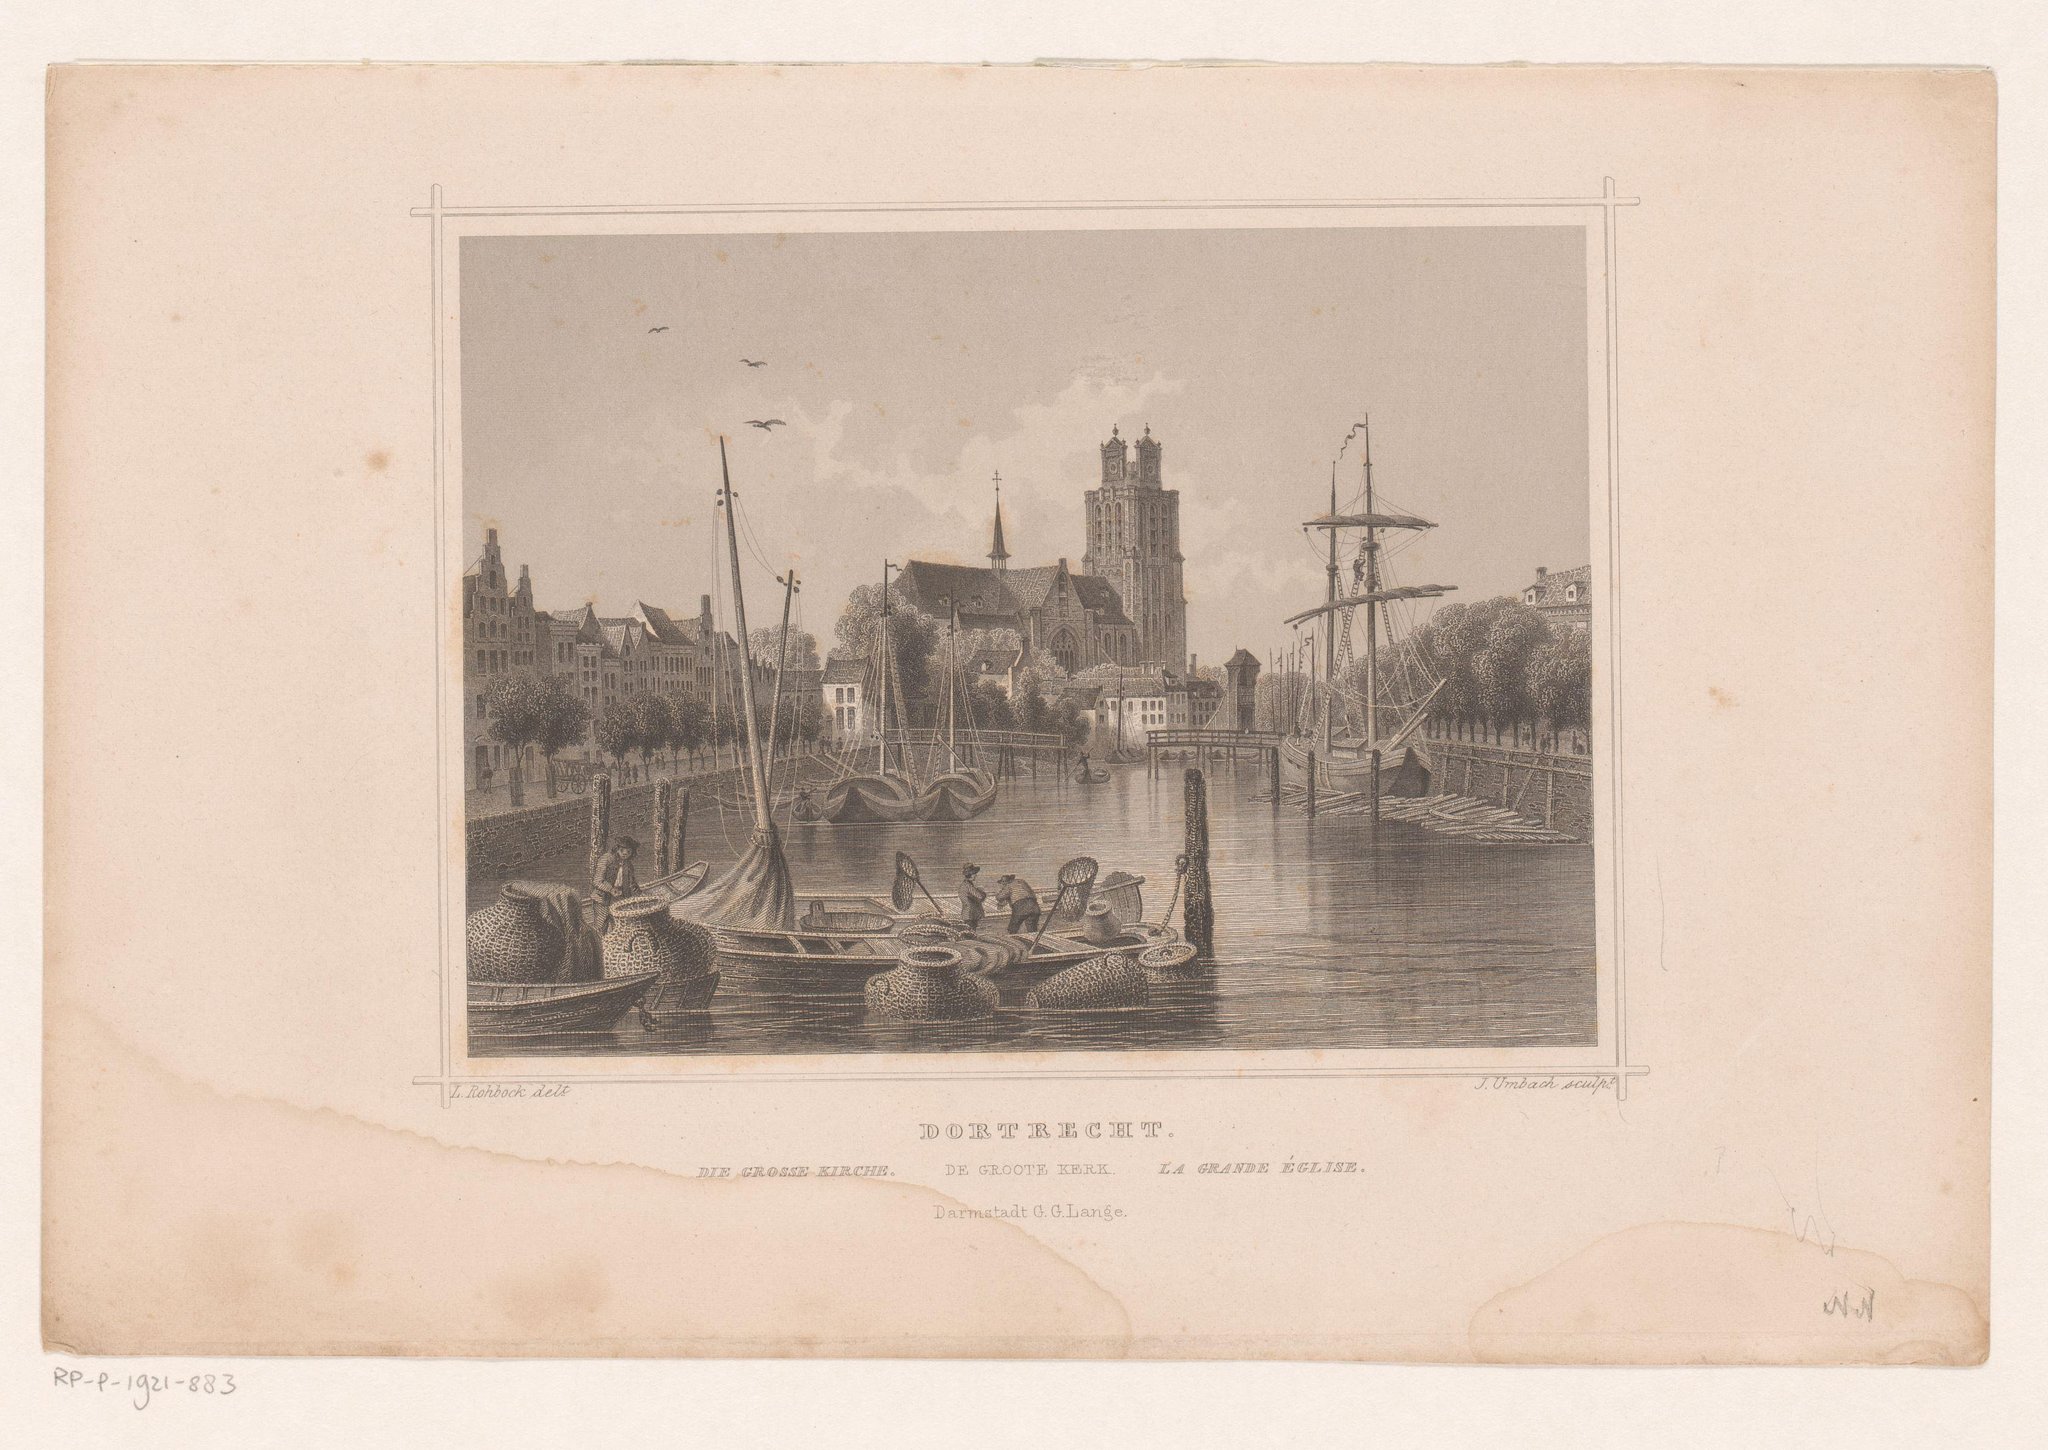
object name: print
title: Gezicht op Dordrecht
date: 1834-1858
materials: paper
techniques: engraving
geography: darmstadt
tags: city-view in general; 'veduta', parts of church exterior and annexes: tower, dordrecht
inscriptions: collector's mark: Lugt 2233